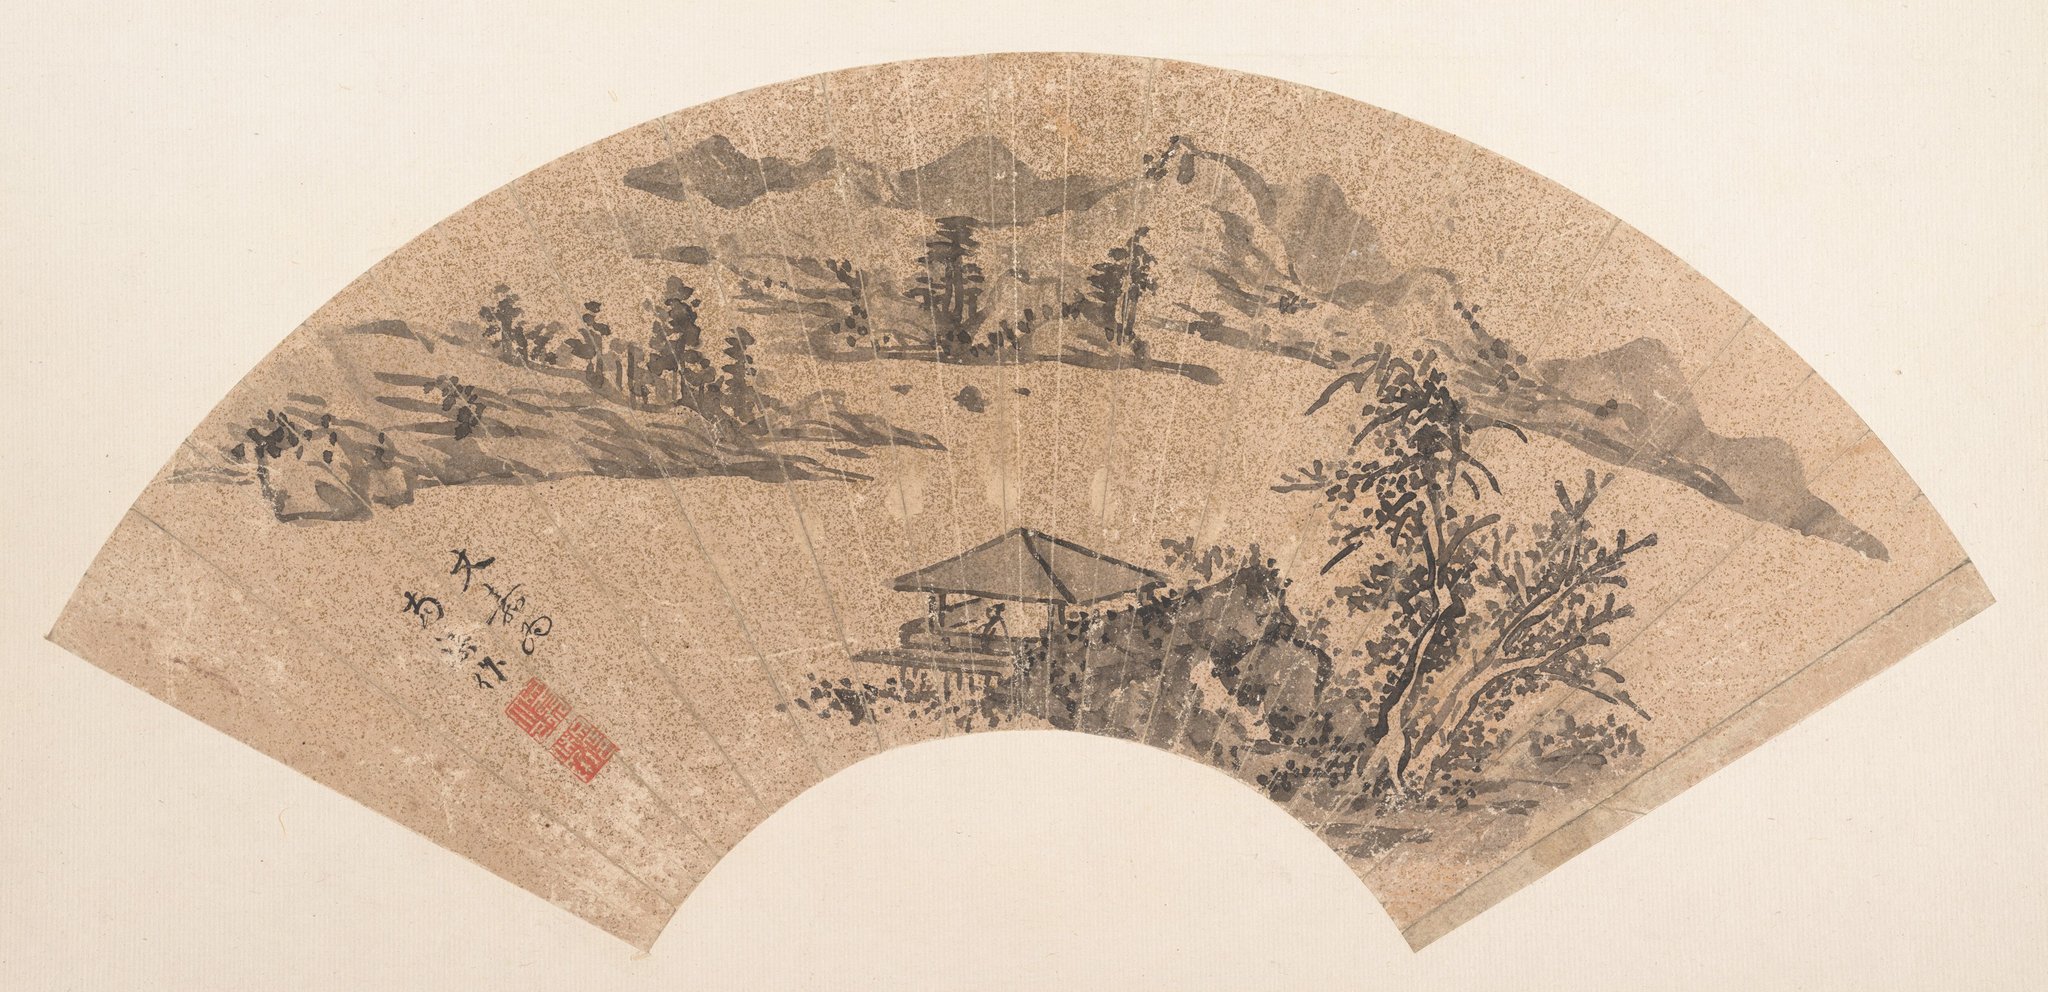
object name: folding fan mounted a an album leaf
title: Pavilion by Lake Shore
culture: chinese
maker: unidentified artist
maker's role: artist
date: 1601-1700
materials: gold, ink, paper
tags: mountains,landscapes,pavilions